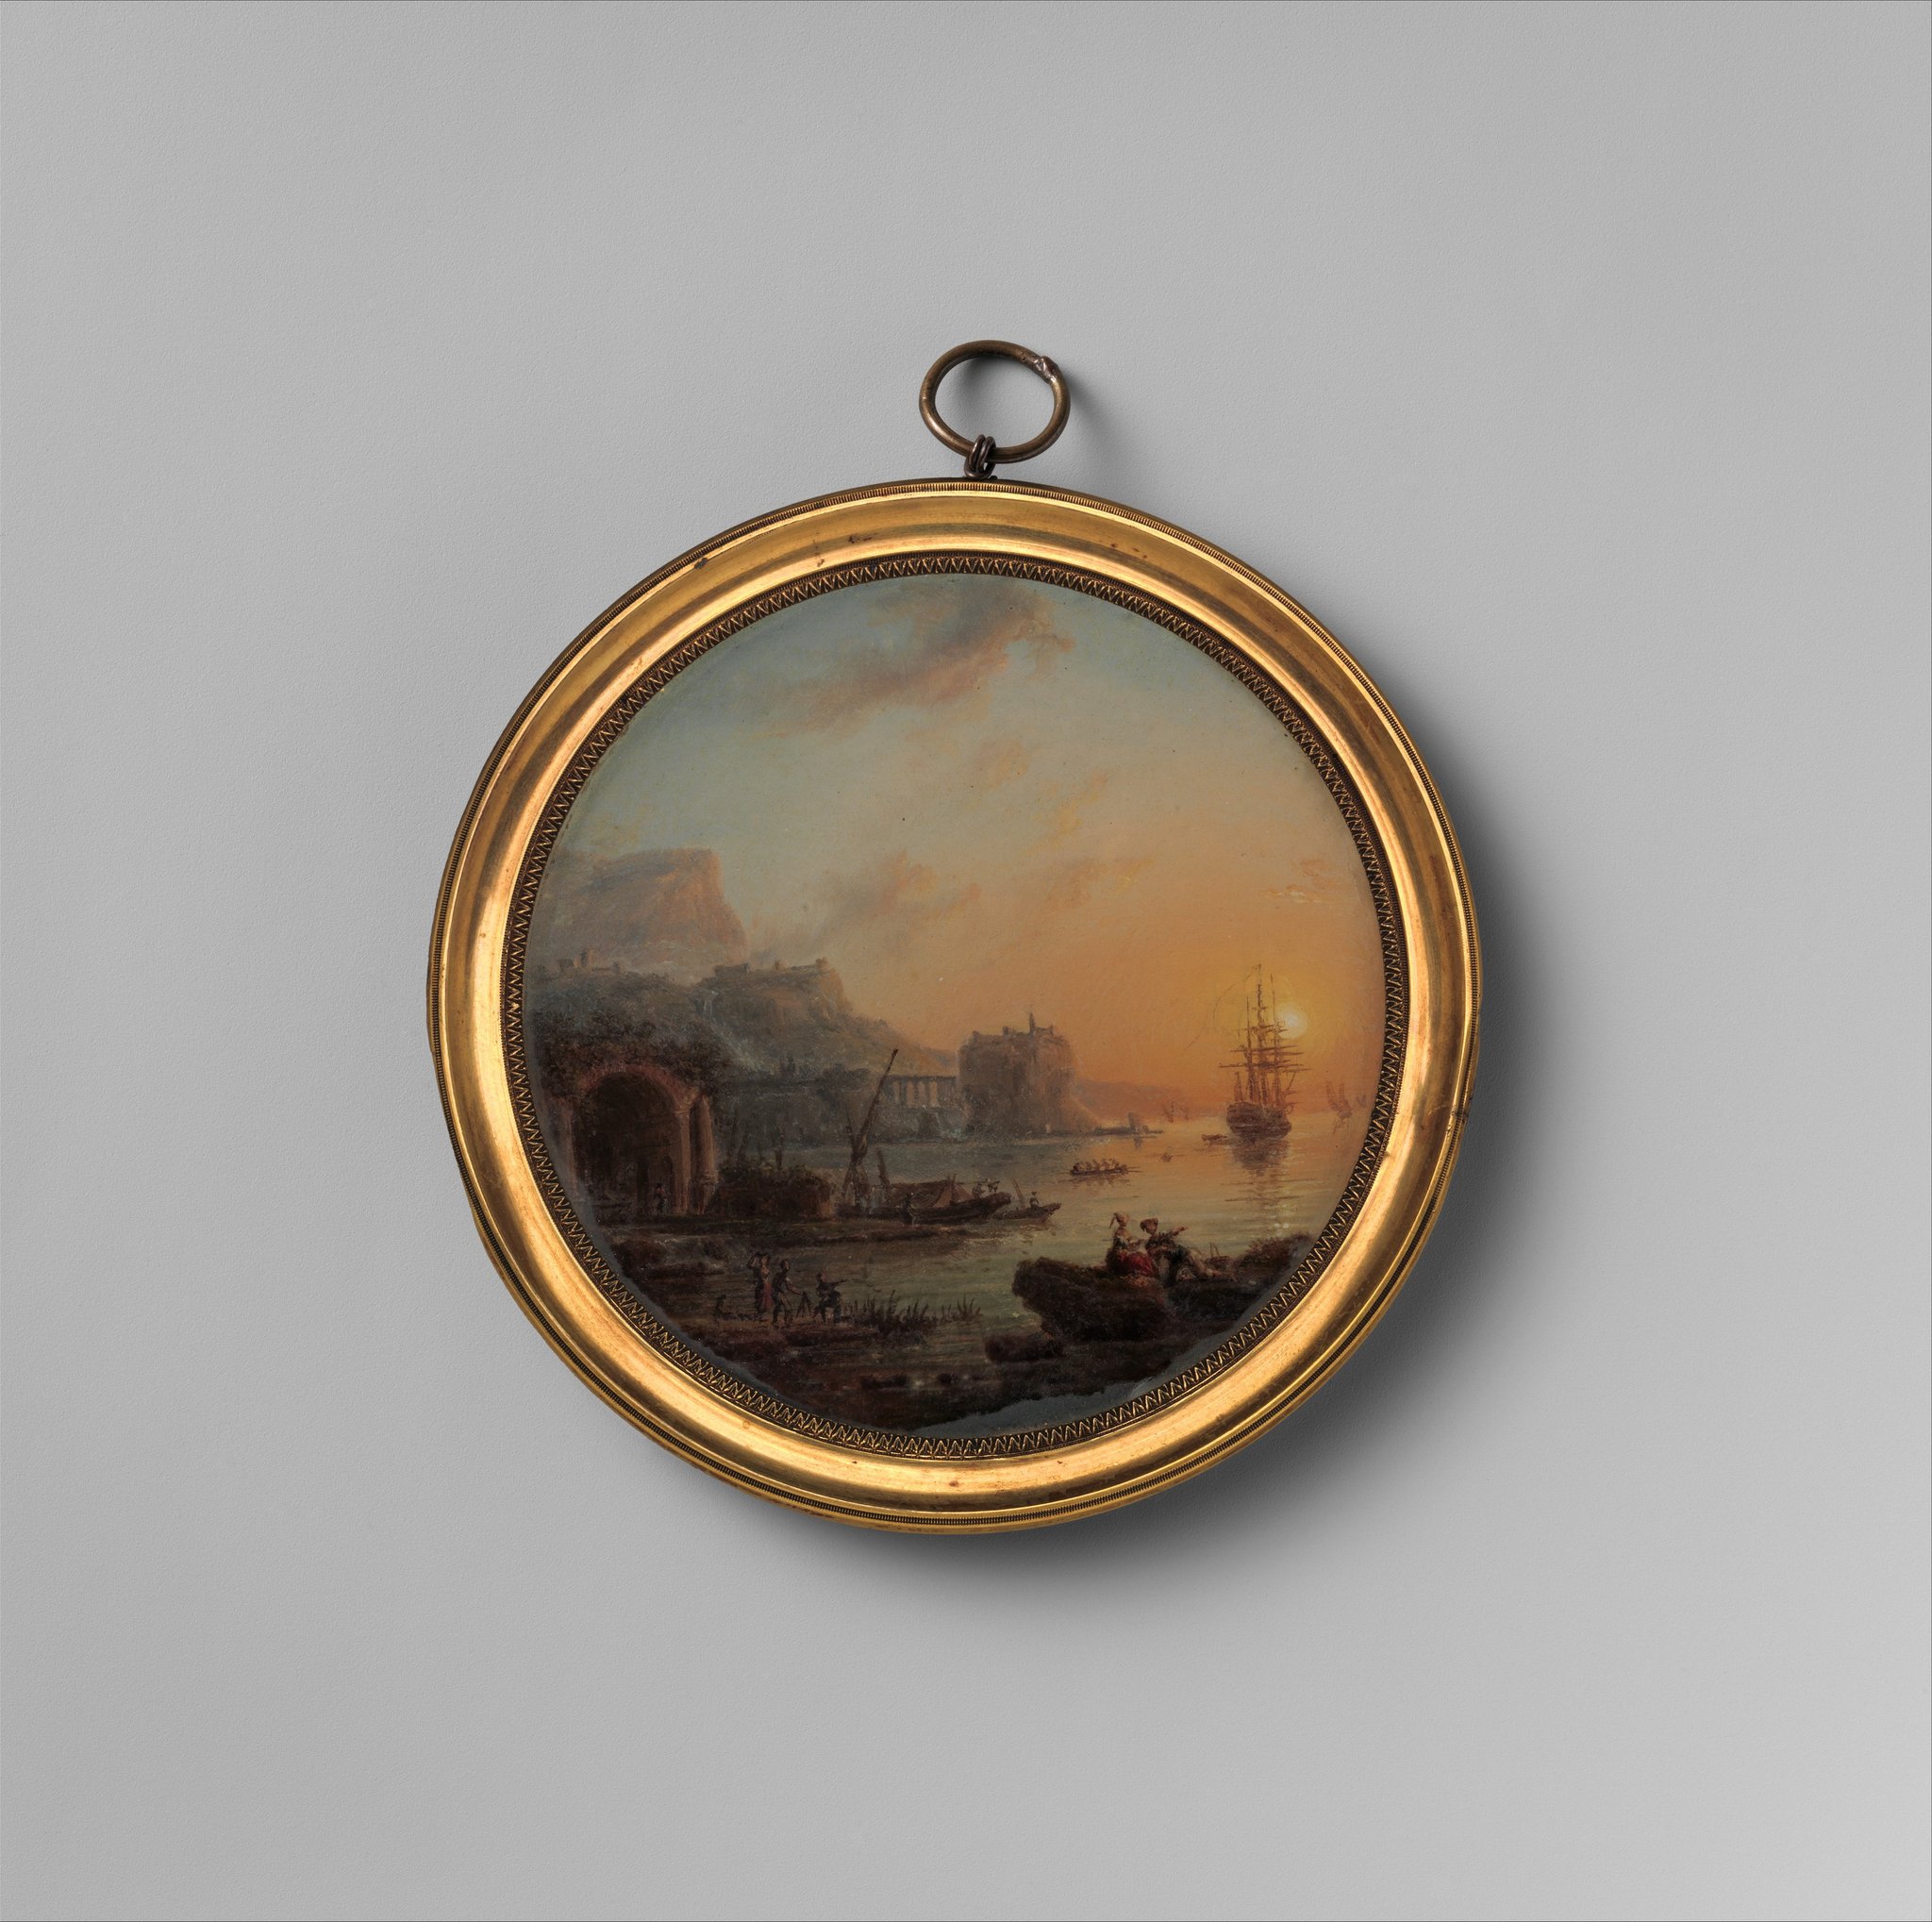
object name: painting, miniature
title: View of a Harbor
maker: french painter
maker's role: artist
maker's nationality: french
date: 1745-1755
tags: boats,harbors